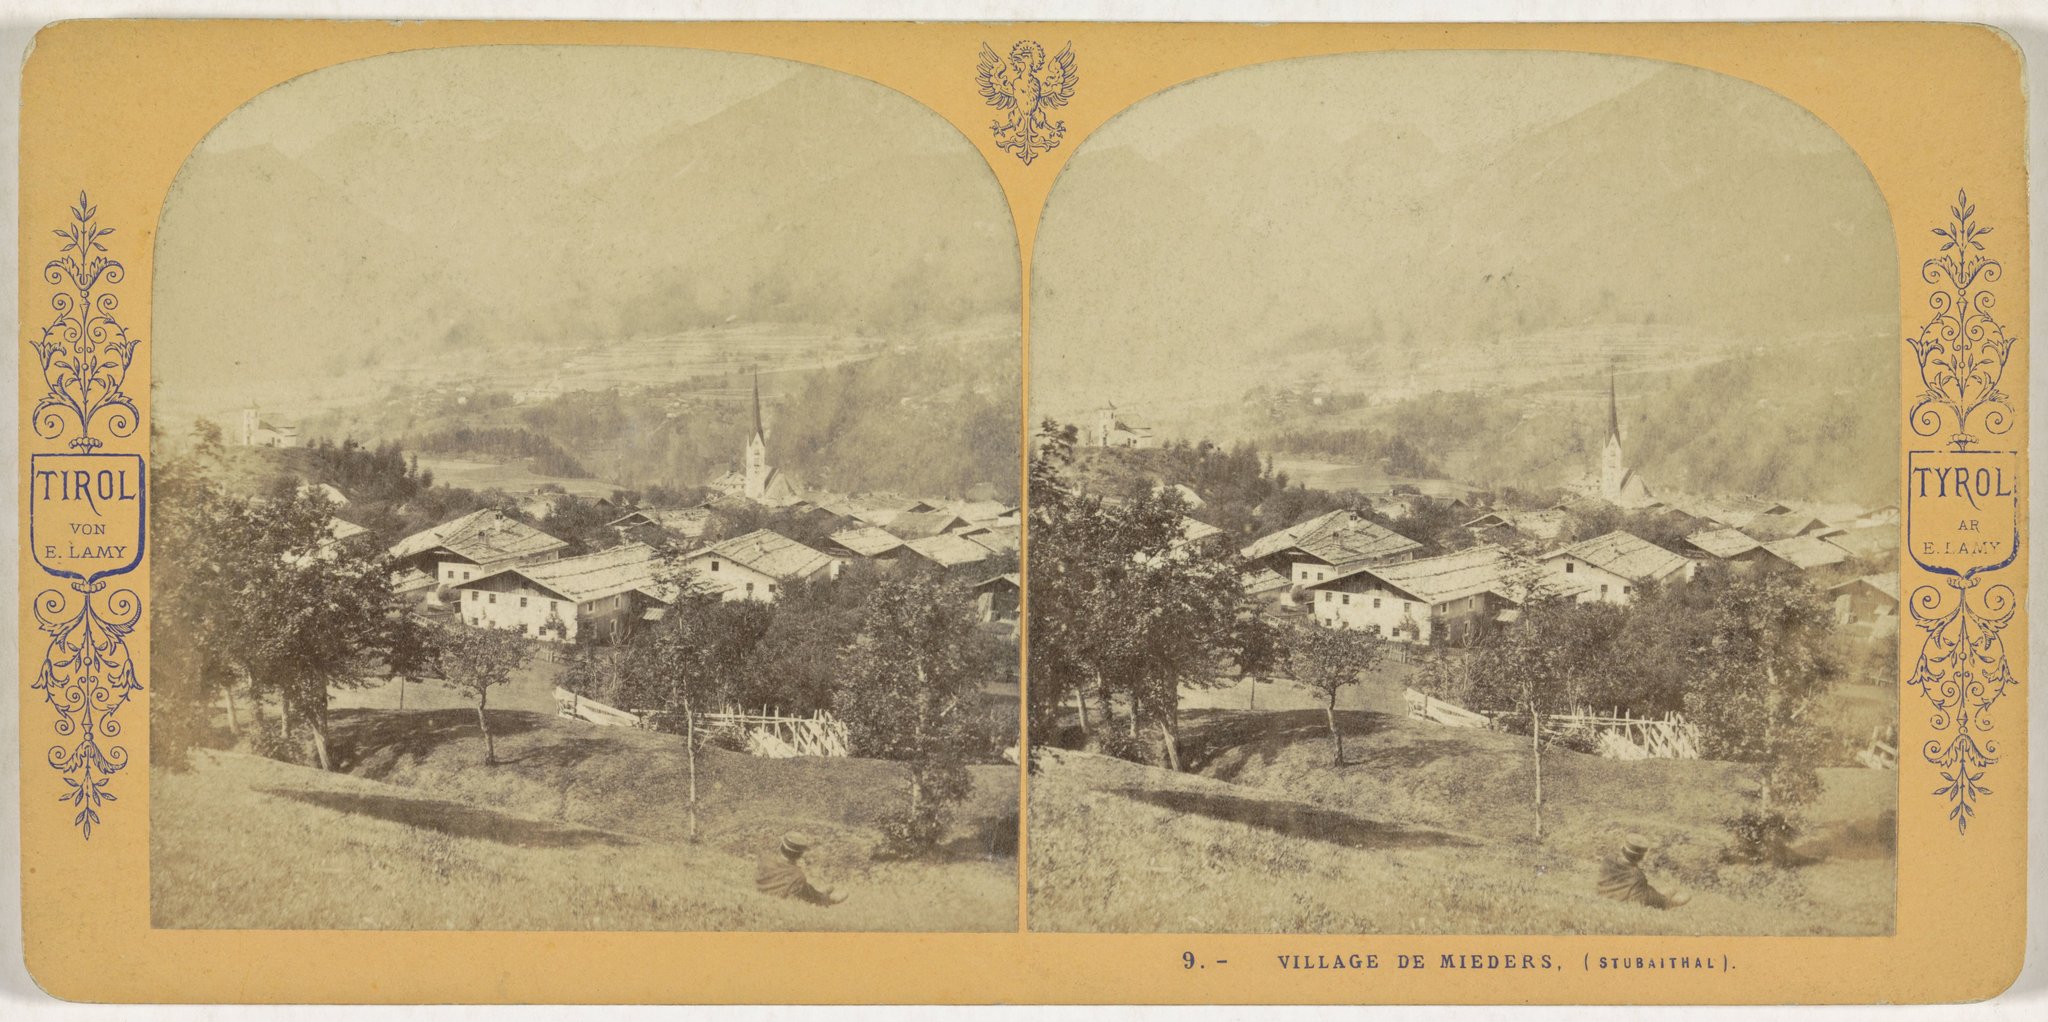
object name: stereograph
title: Tirol / Tyrol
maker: ernest eléonor pierre lamy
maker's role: publisher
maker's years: 1828-1900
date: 1869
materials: cardboard, paper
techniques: albumen print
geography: mieders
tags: prospect of village, silhouette of village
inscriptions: number: ‘9.’